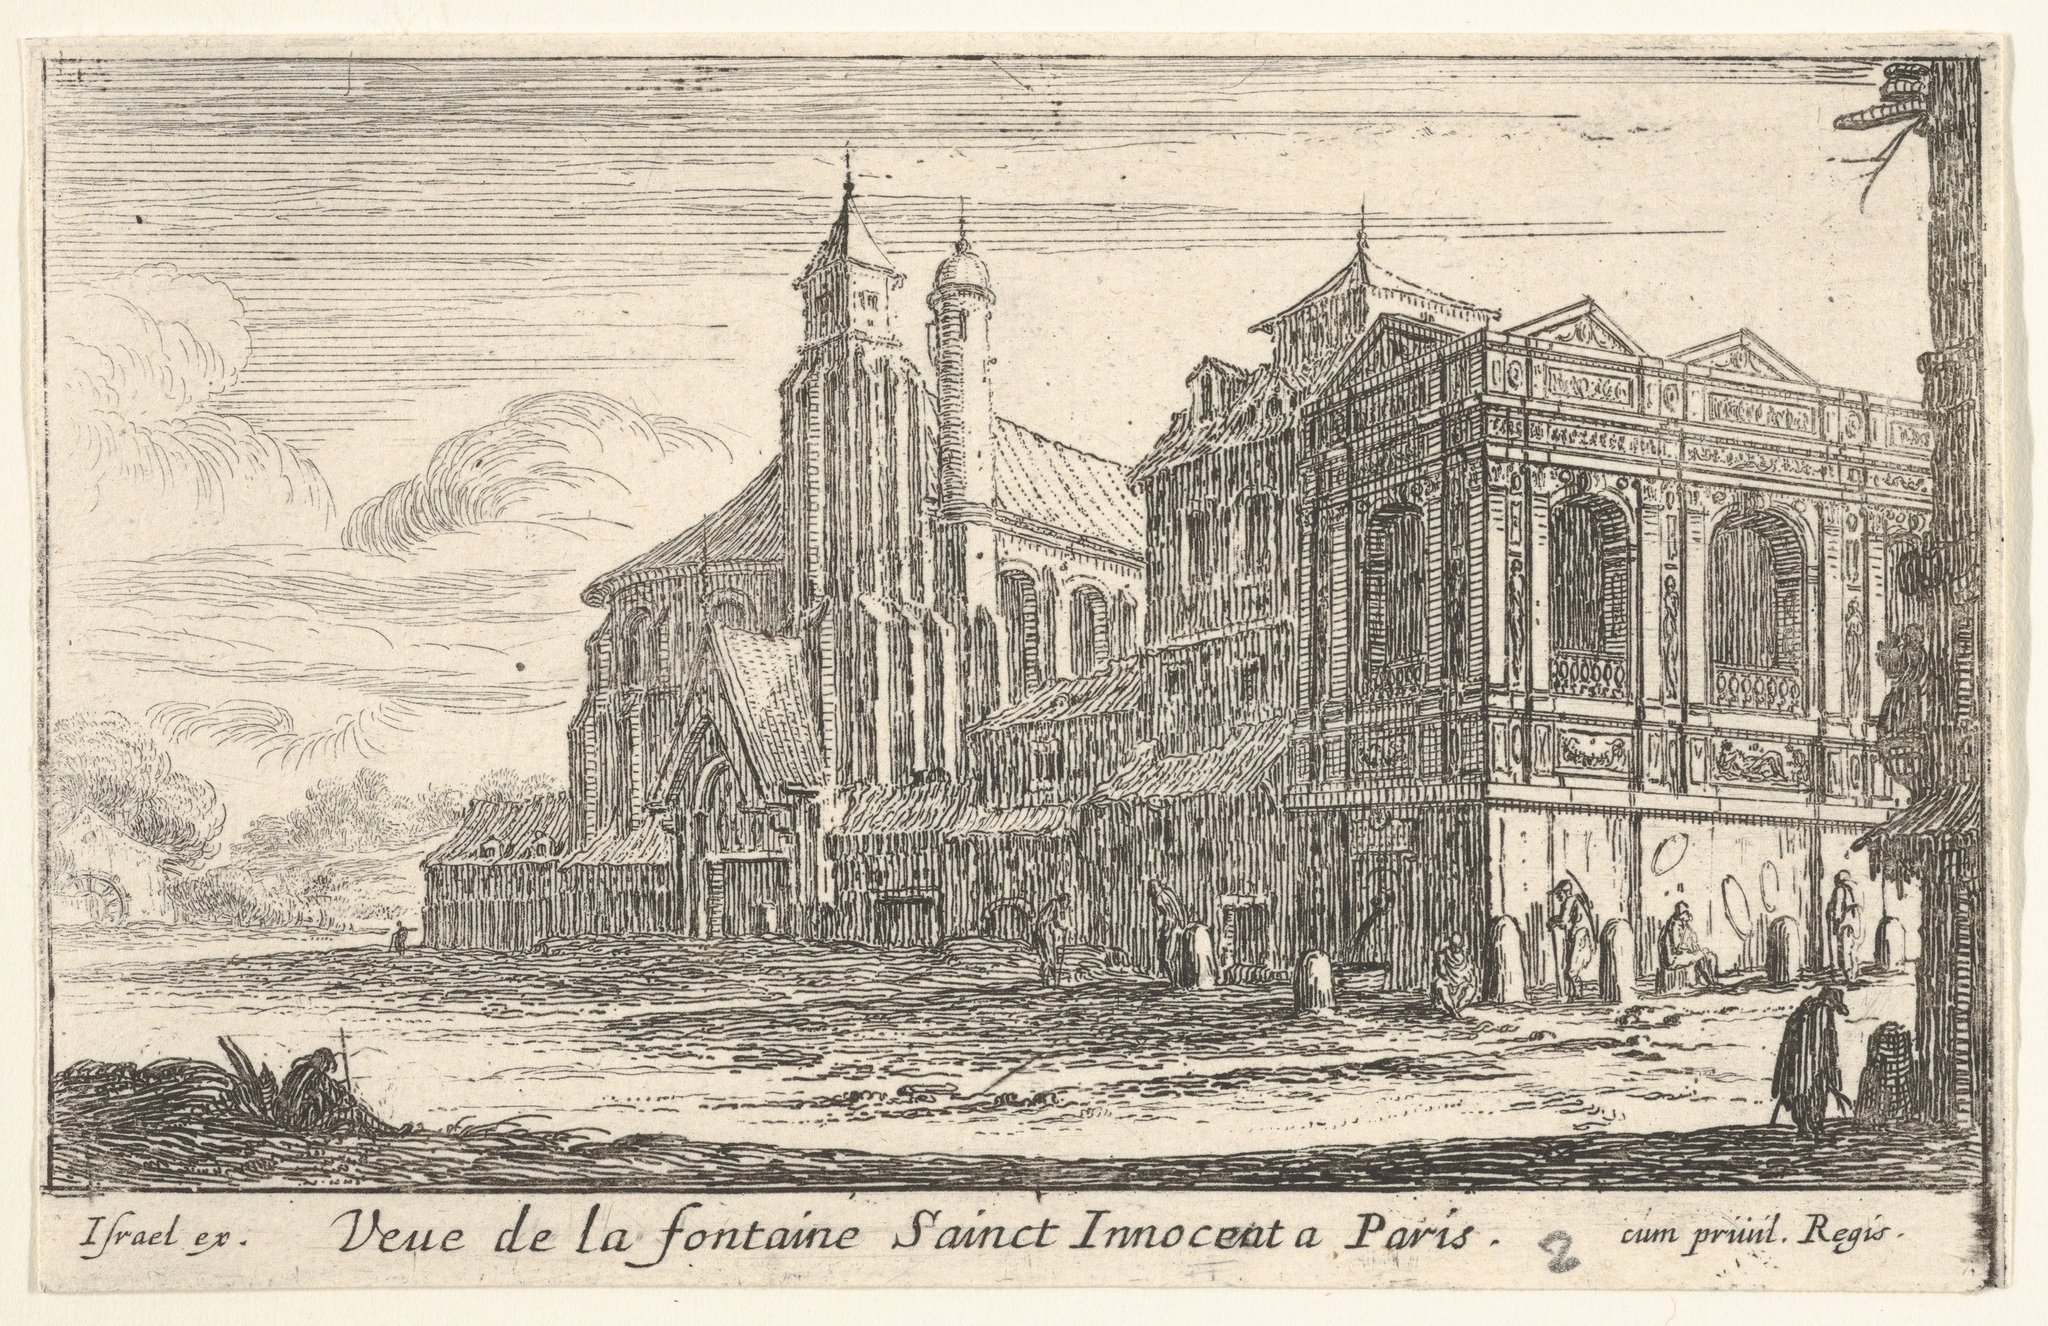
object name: print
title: View of the Fountain of the Innocents, Paris, with the Church of the Holy Innocents beyond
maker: israël silvestre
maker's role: artist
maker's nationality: french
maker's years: 1621-1691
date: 1636-1691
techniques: etching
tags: fountains,boats,paris